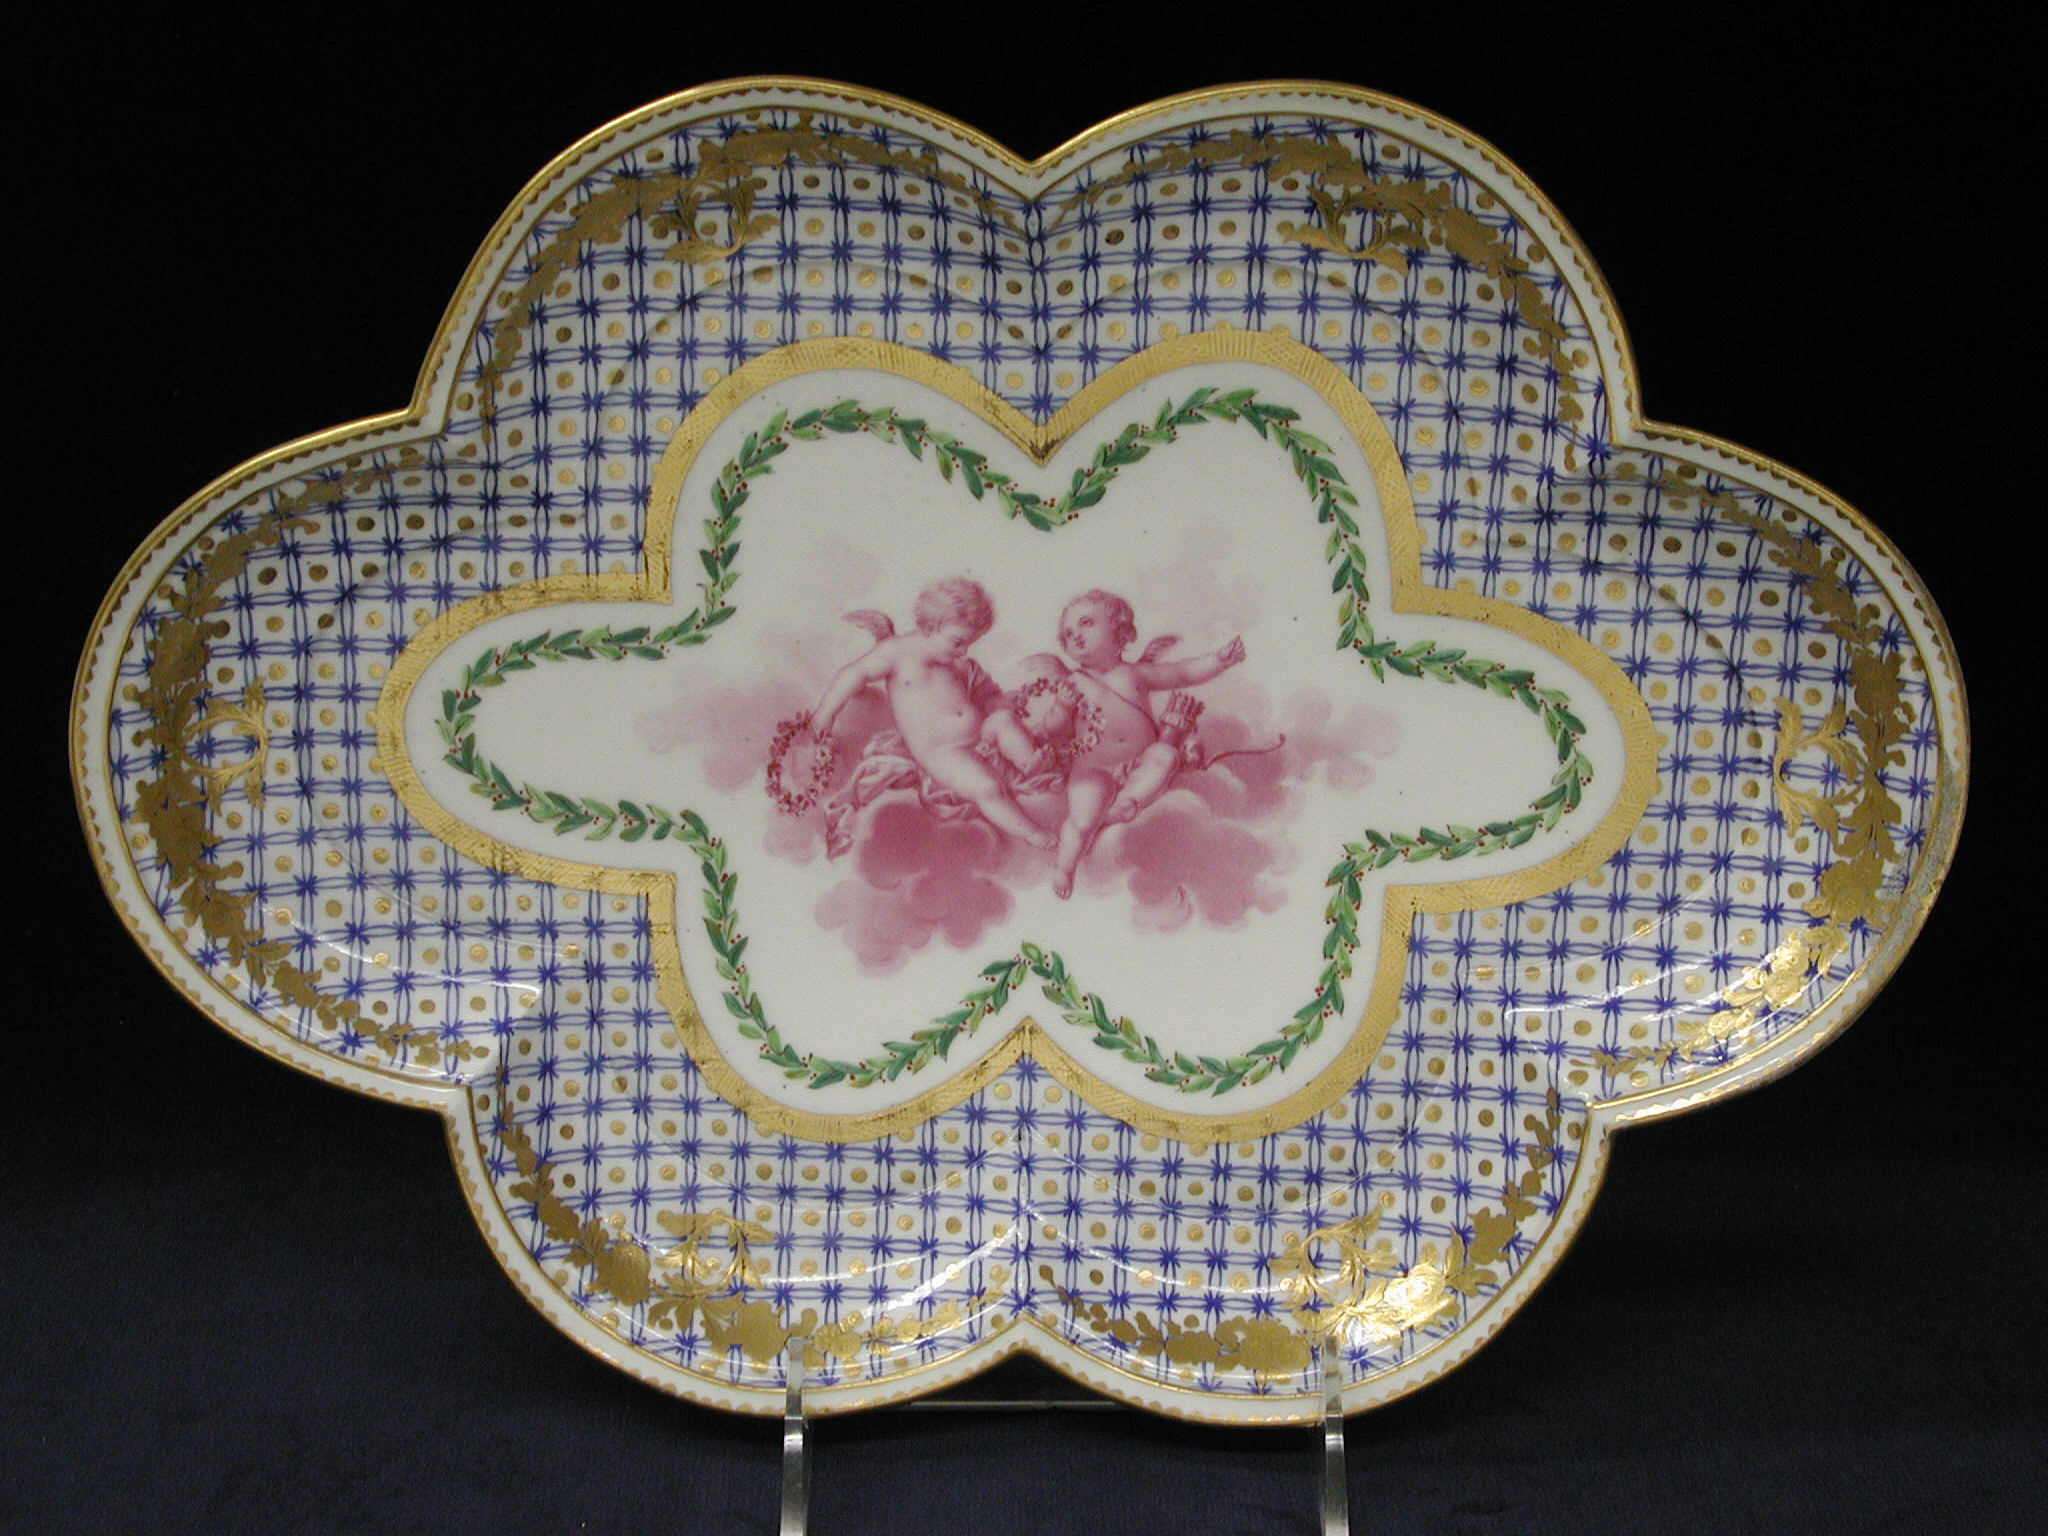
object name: tray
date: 1701-1900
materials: soft paste porcelain